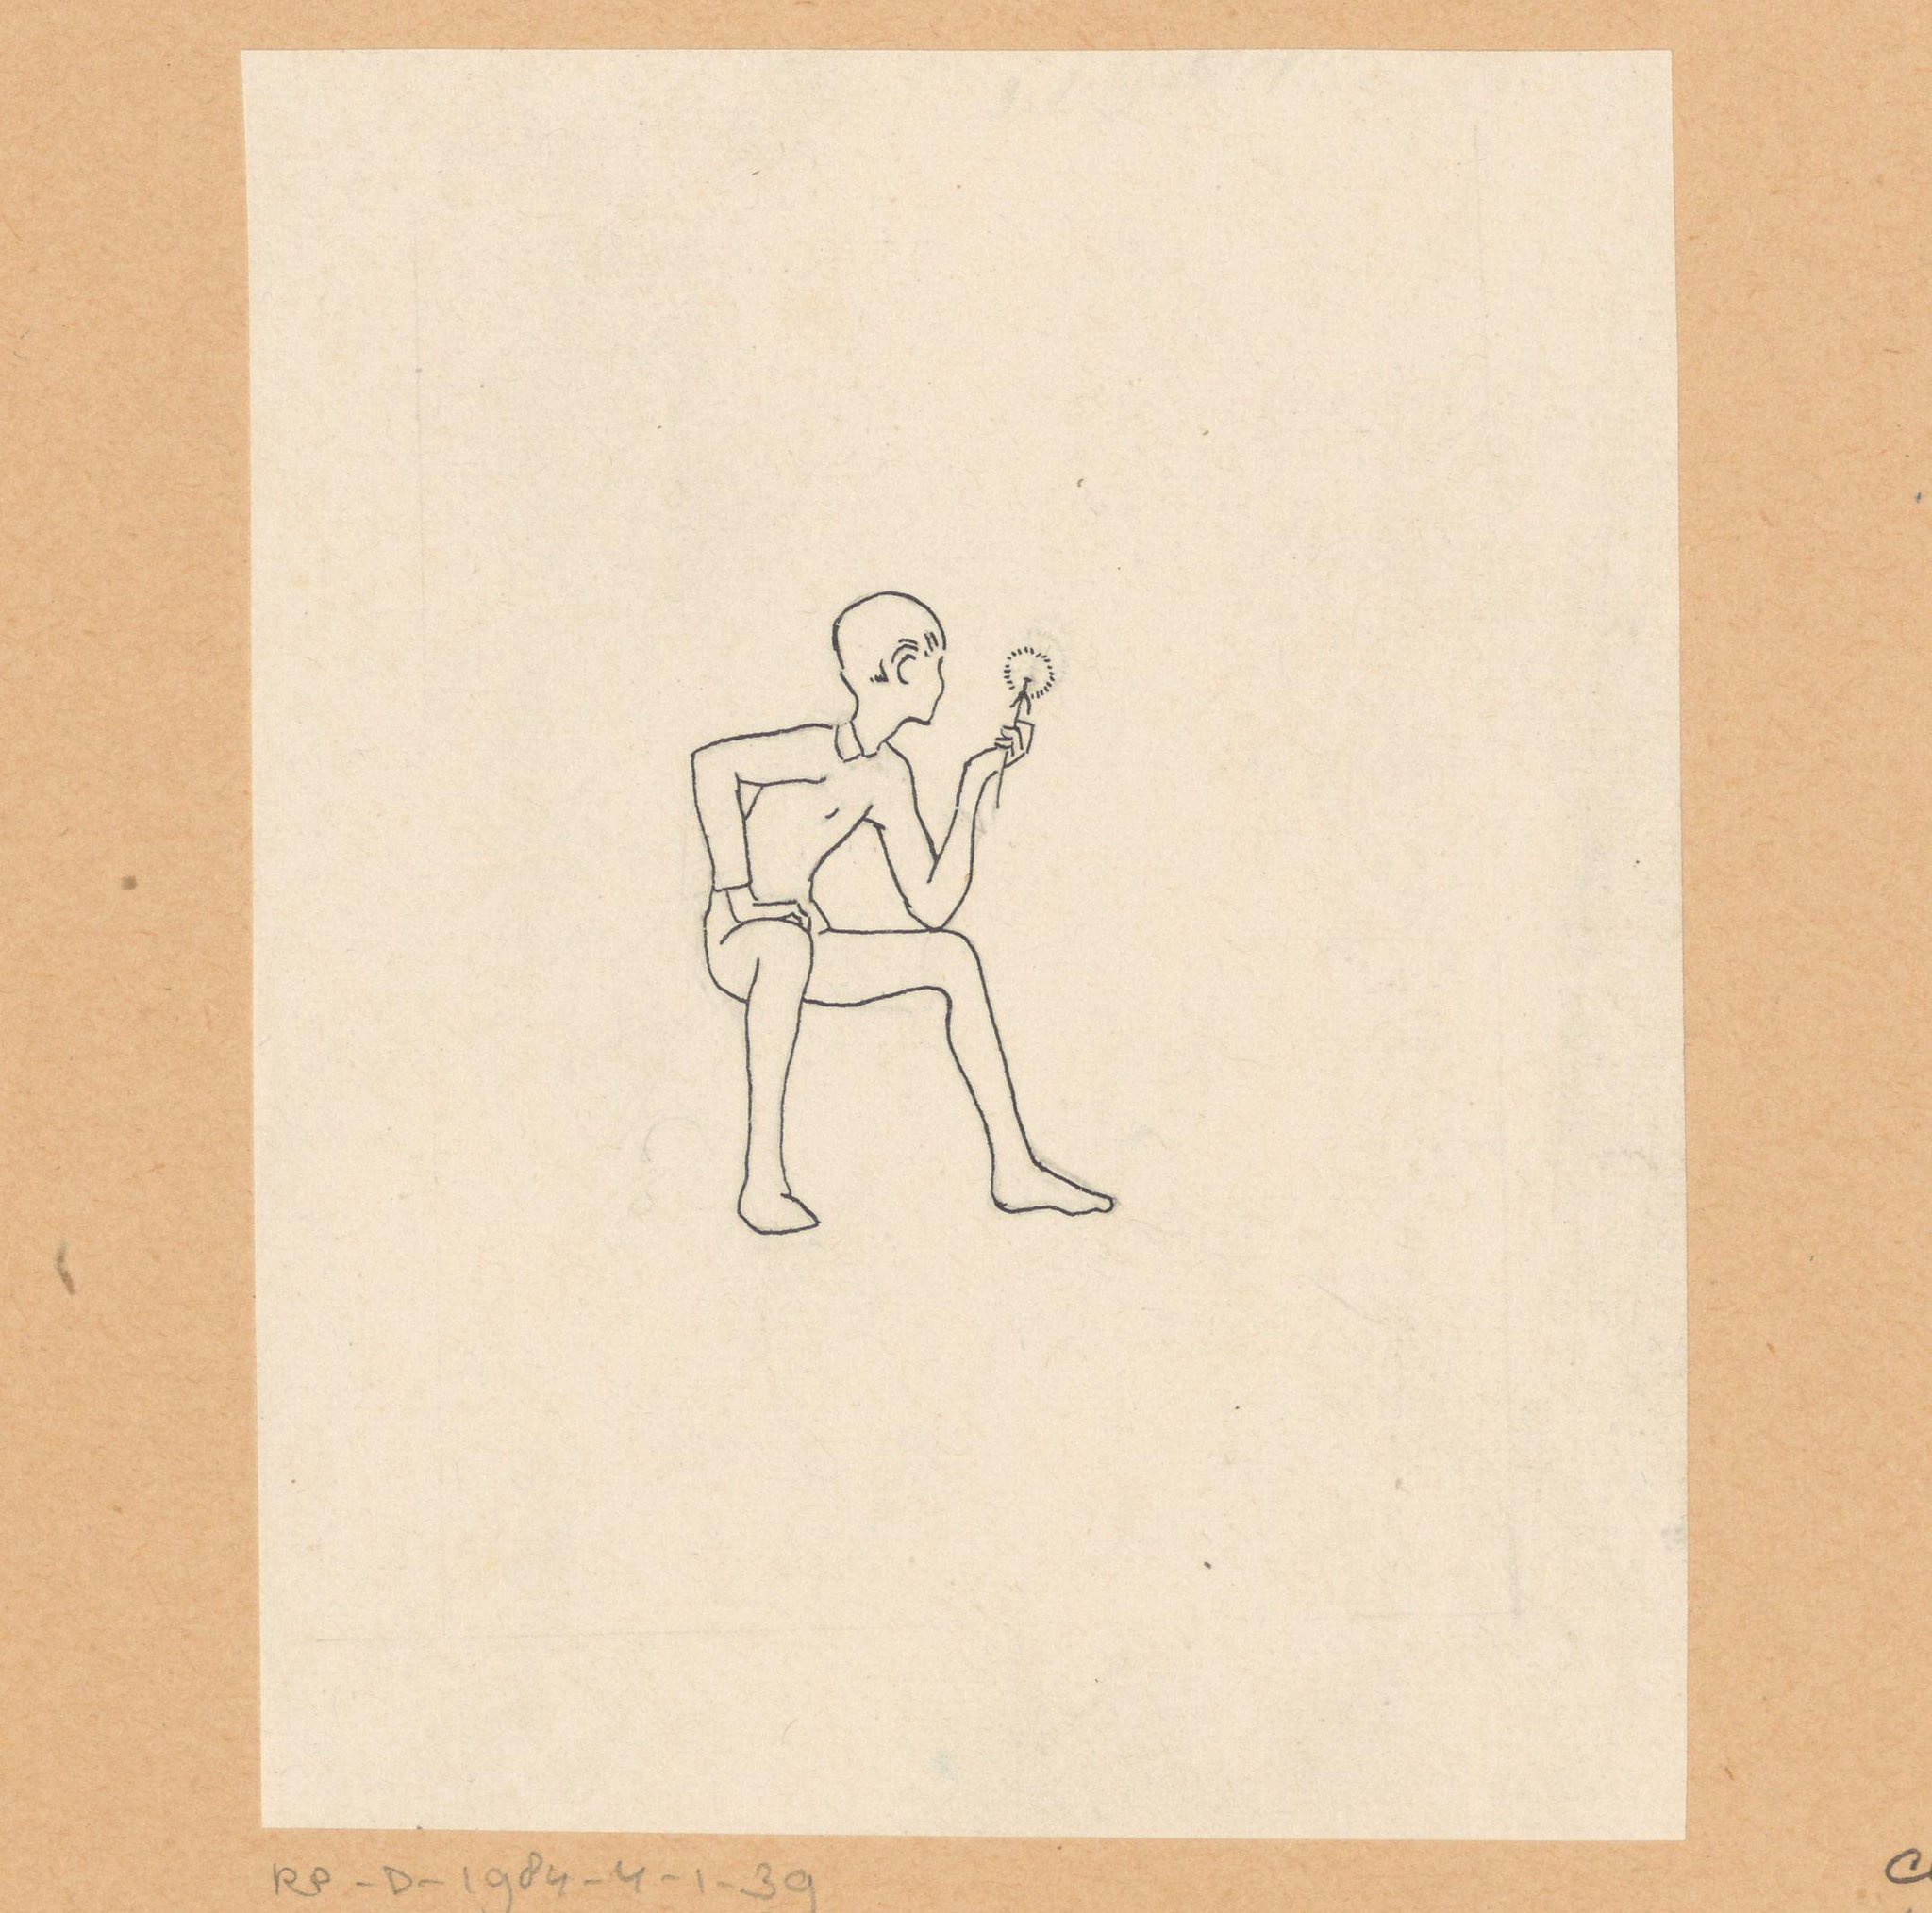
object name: design drawing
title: Zittende jongen. Ontwerp voor ex libris van Otto Verhagen (II)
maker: otto verhagen (i)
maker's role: draughtsman, print maker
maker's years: 1885-1951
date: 1929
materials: ink, paper, pencil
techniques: drawing, pen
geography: netherlands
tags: maarssen, painter, print maker, otto verhagen (ii), sitting figure, flowers: dandelion, boy (child between toddler and youth)